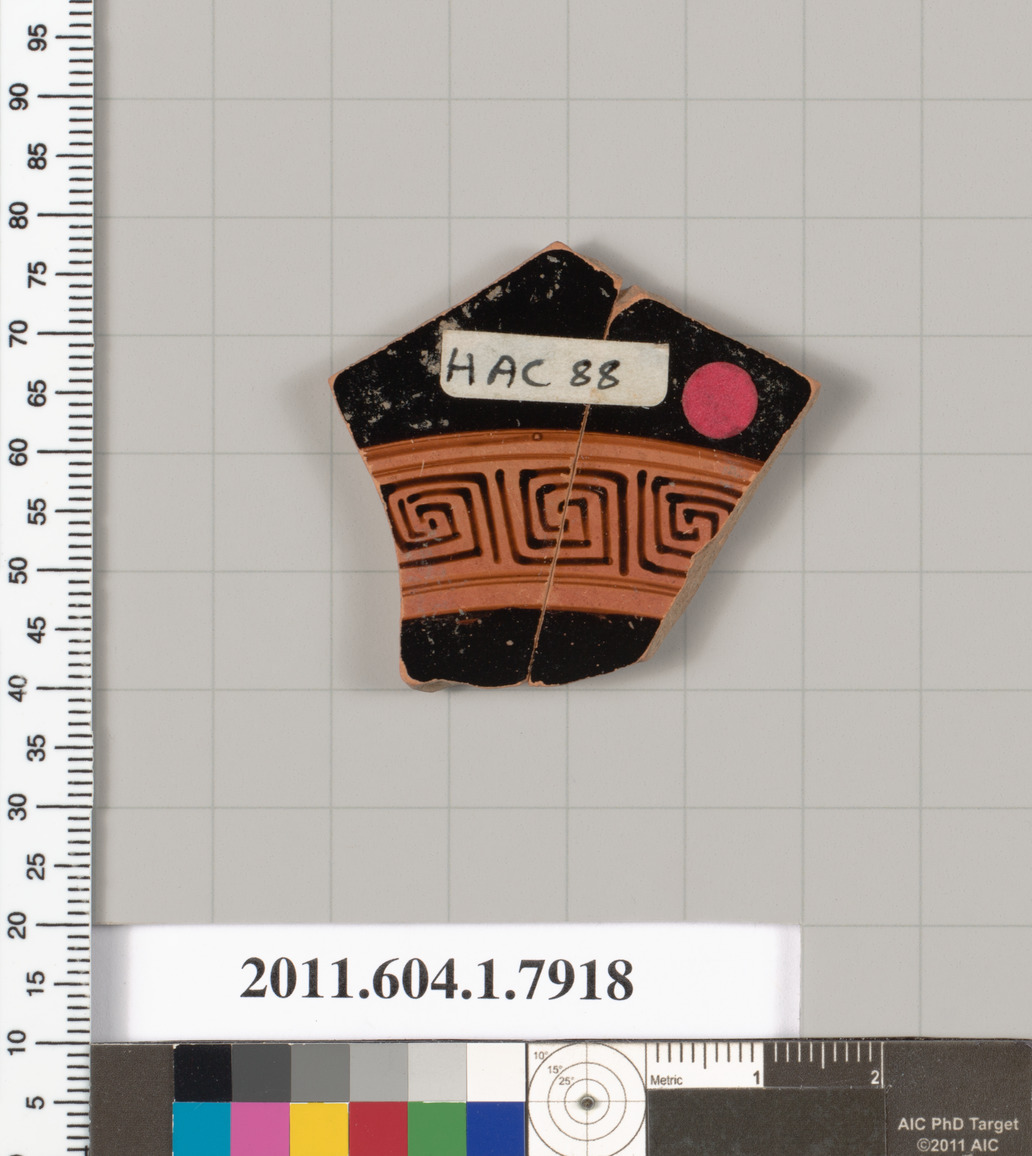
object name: kylix fragment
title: Terracotta fragment of a kylix (drinking cup)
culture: greek, attic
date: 460-450 BCE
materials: terracotta